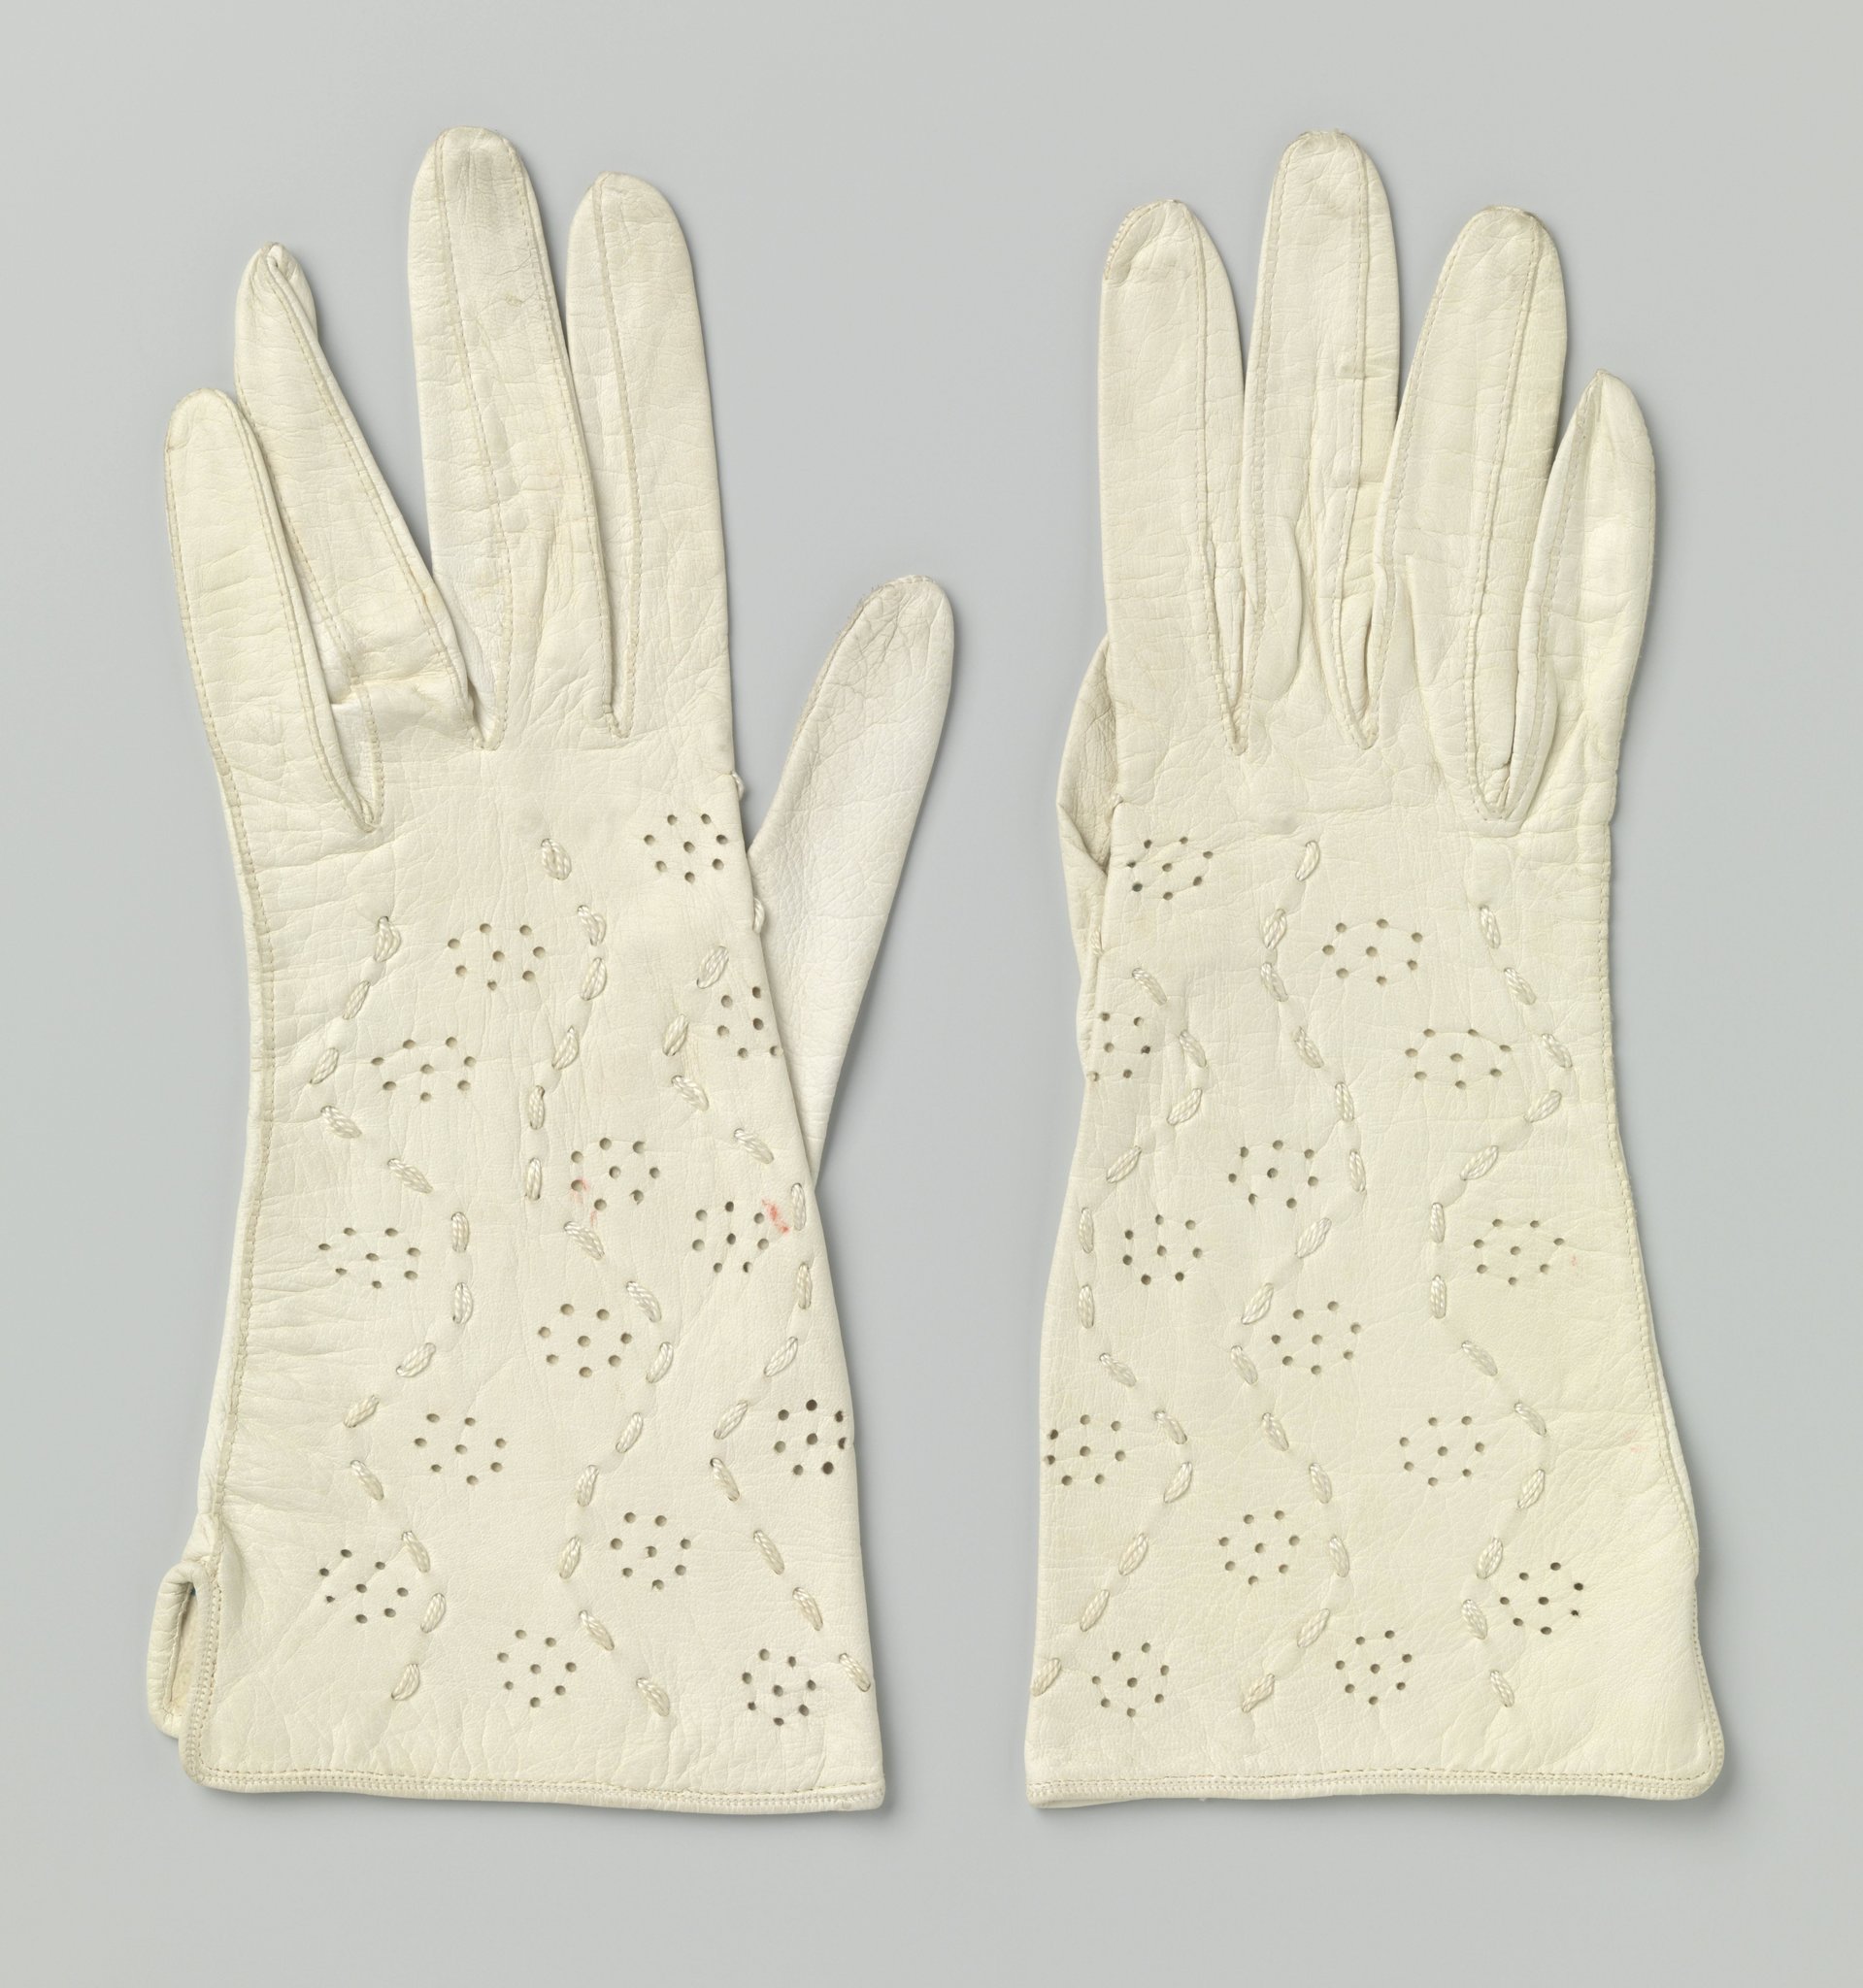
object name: womenswear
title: Handschoen van glacéleer met opening aan zijnaad, op hand perforaties waartussen slingerende versiering van koord dat door perforaties is gehaald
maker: Anonymous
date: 1925-1950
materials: glazing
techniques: perforating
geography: france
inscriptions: stamp: ‘tekst’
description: Rechterhandschoen van glacéleer. Opening aan de zijnaad. Op de hand zijn perforaties aangebracht, waartussen slingerende versiering van naturelkleurig koord dat door de perforaties is gehaald.